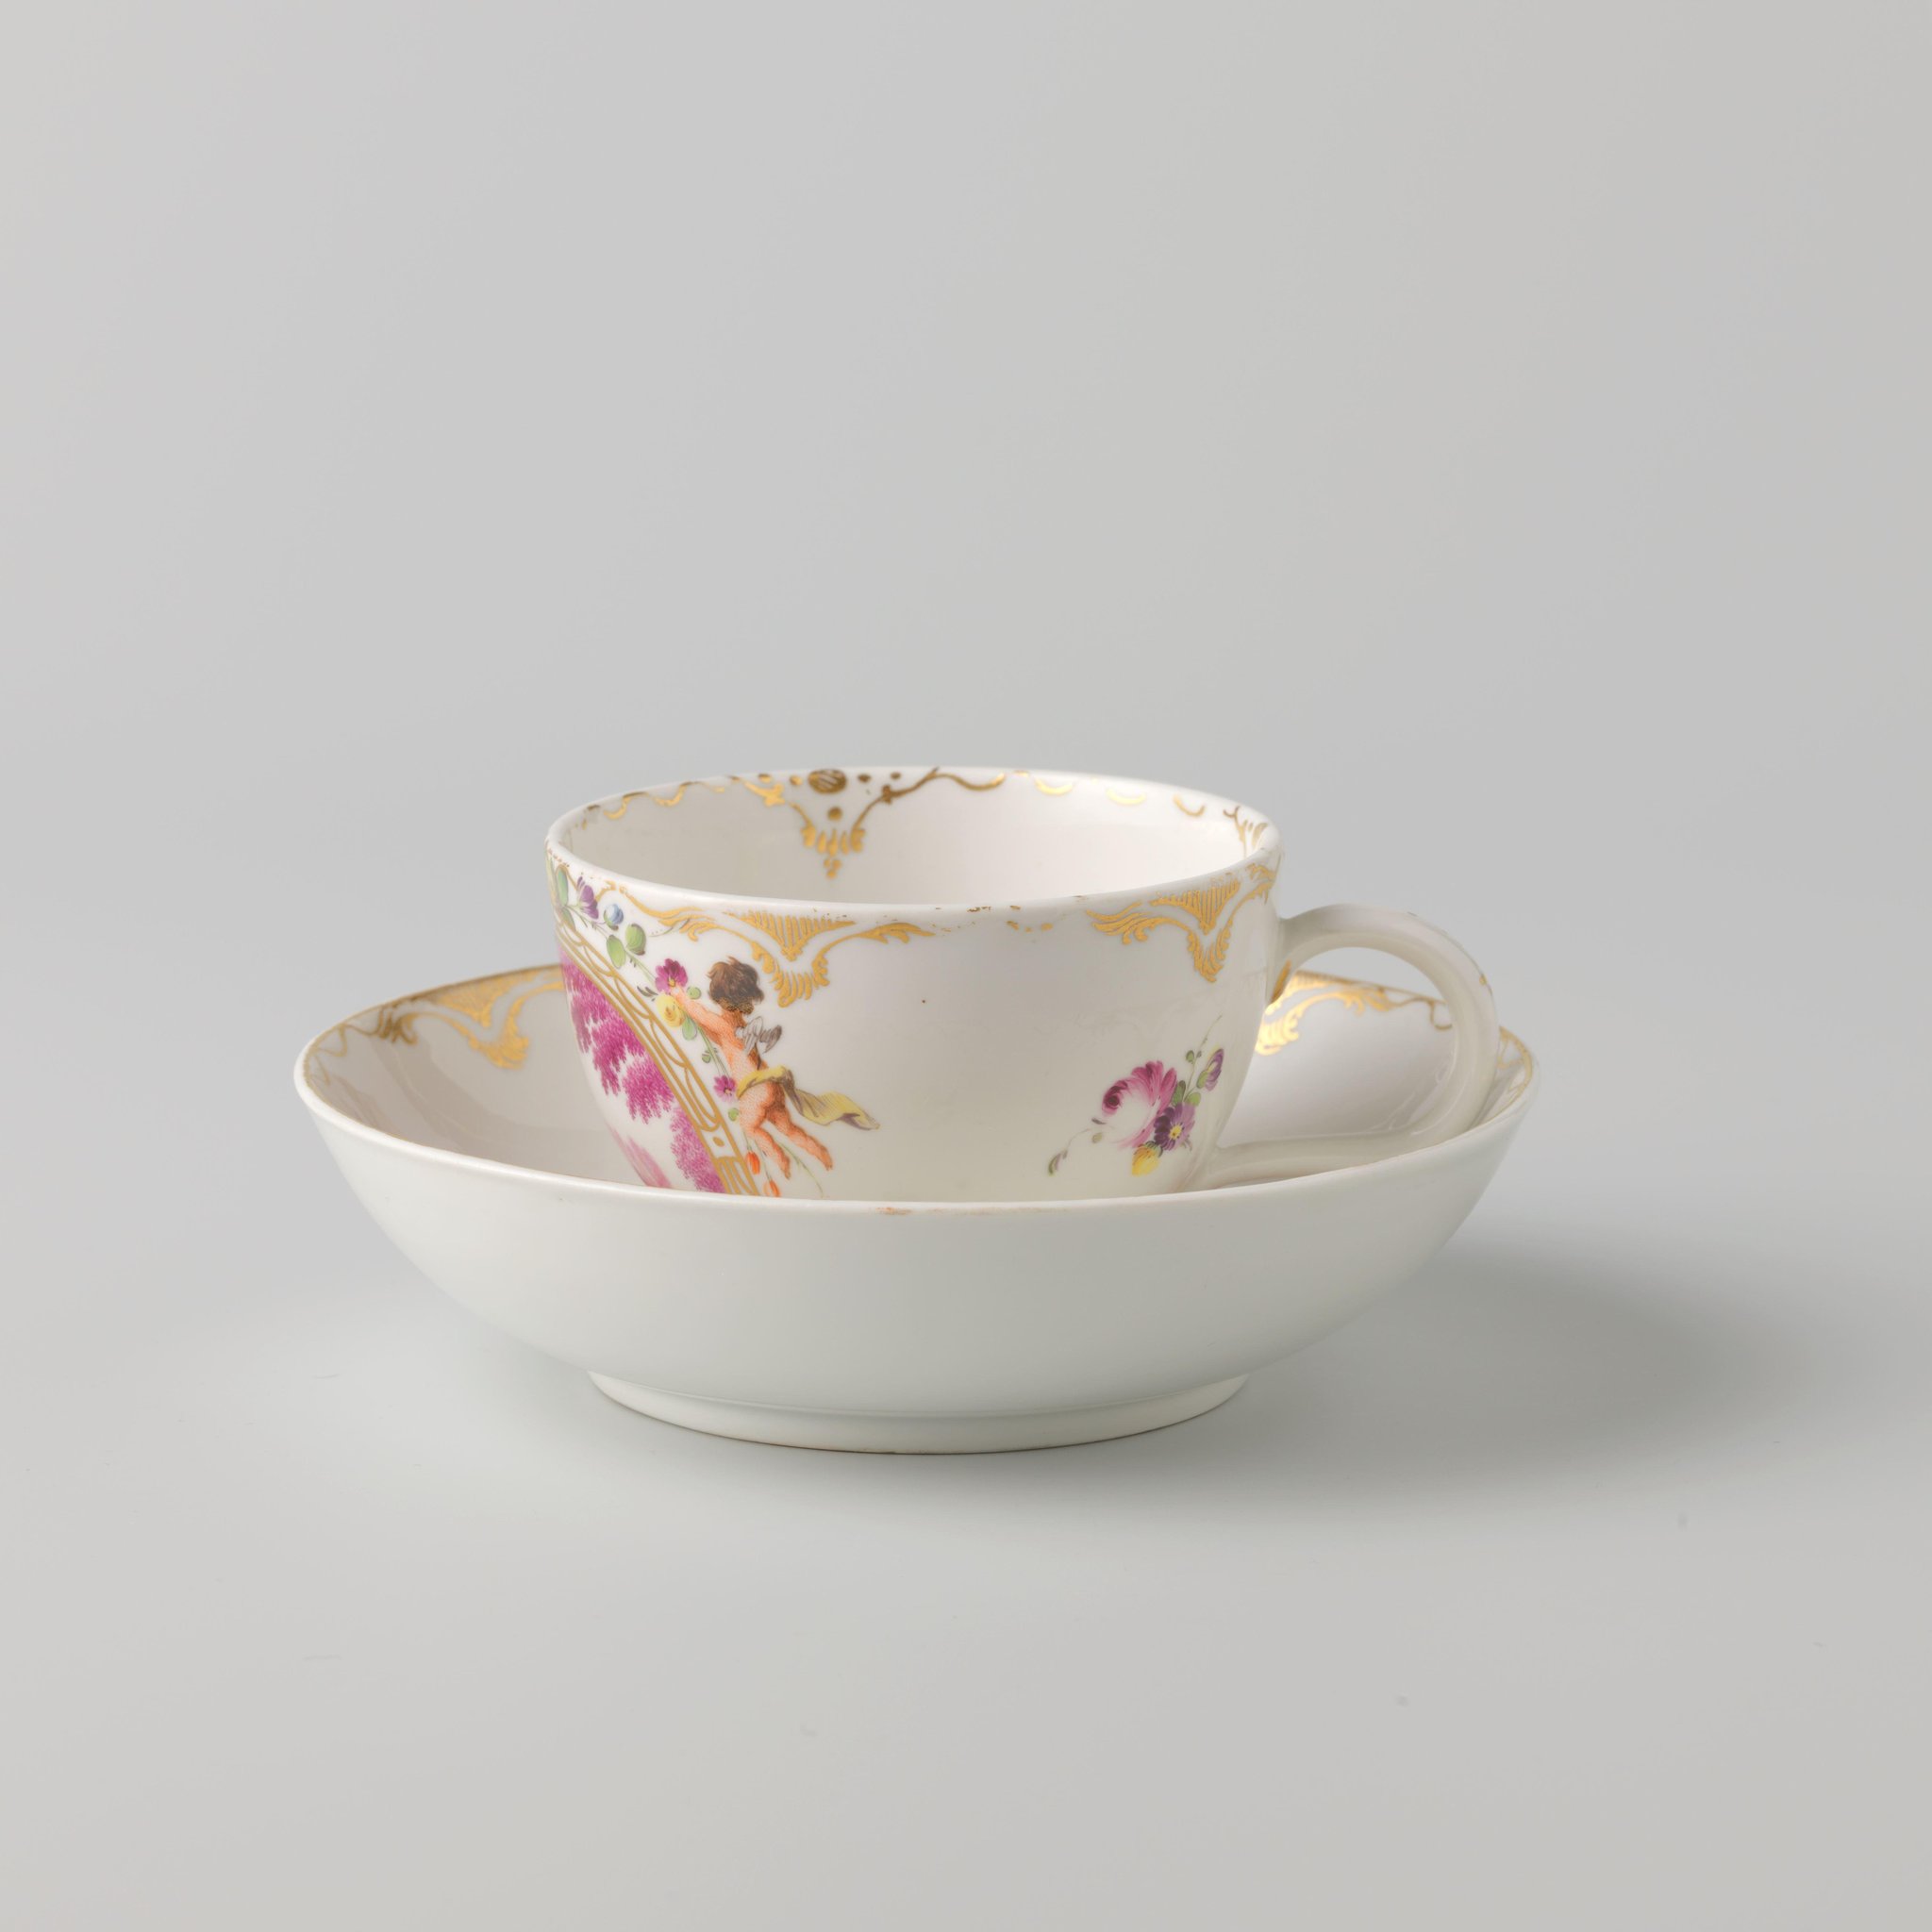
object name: kop en schotel, kop en schotel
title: Schotel met medaillon met weilandschap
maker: Anonymous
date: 1777-1790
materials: porcelain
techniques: painted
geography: germany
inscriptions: mark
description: Schotel beschilderd met veelkleurige weilandschap met figuren en koeien binnen een medaillon versierd met bloemguirlandes en putti. Langs de rand, rocaille ornament. Gemerkt met een ooievaar in blauw op het glazuur. N.B. Duits porselein beschilderd in Den Haag.